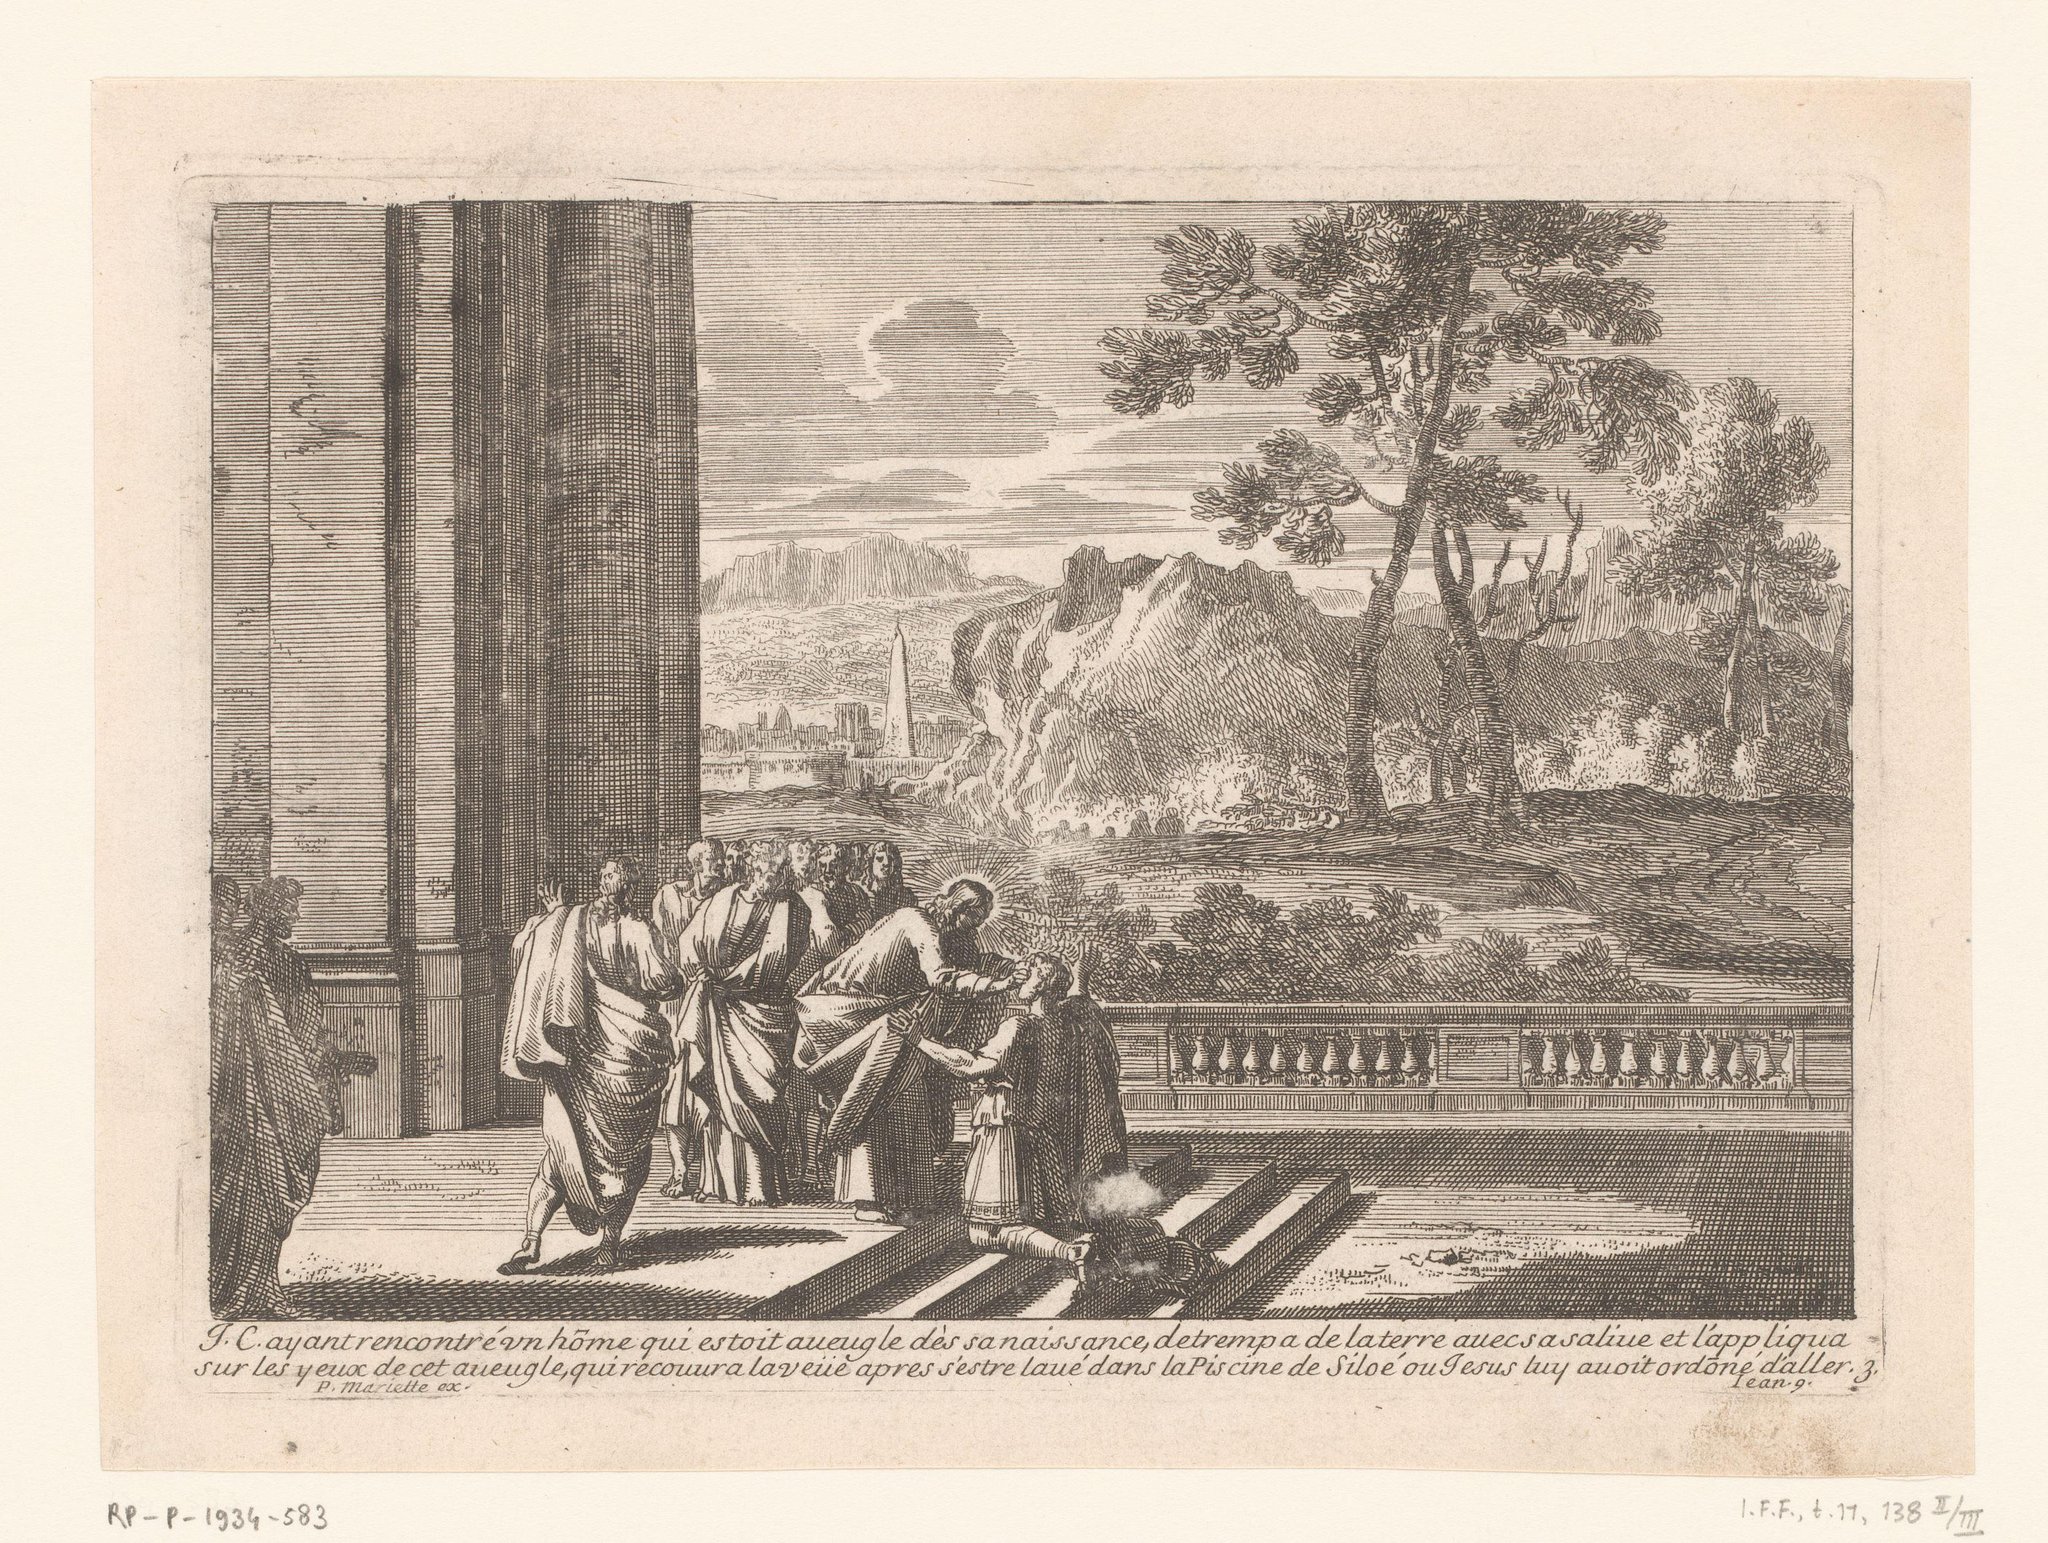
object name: print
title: La vie de Jésus-Christ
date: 1628-1682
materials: paper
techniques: etching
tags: healing of a man born blind: christ touches his eyes with an 'ointment' of dust and spittle (john 9)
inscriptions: collector's mark: Lugt 2228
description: Maakt deel uit van een zesdelige serie met scènes uit het leven van Christus, opgedragen aan François de Rostaing. Enkel de laatste plaat uit de serie is door Lepautre gesigneerd. Zie IFF 17e siècle, p. 101.